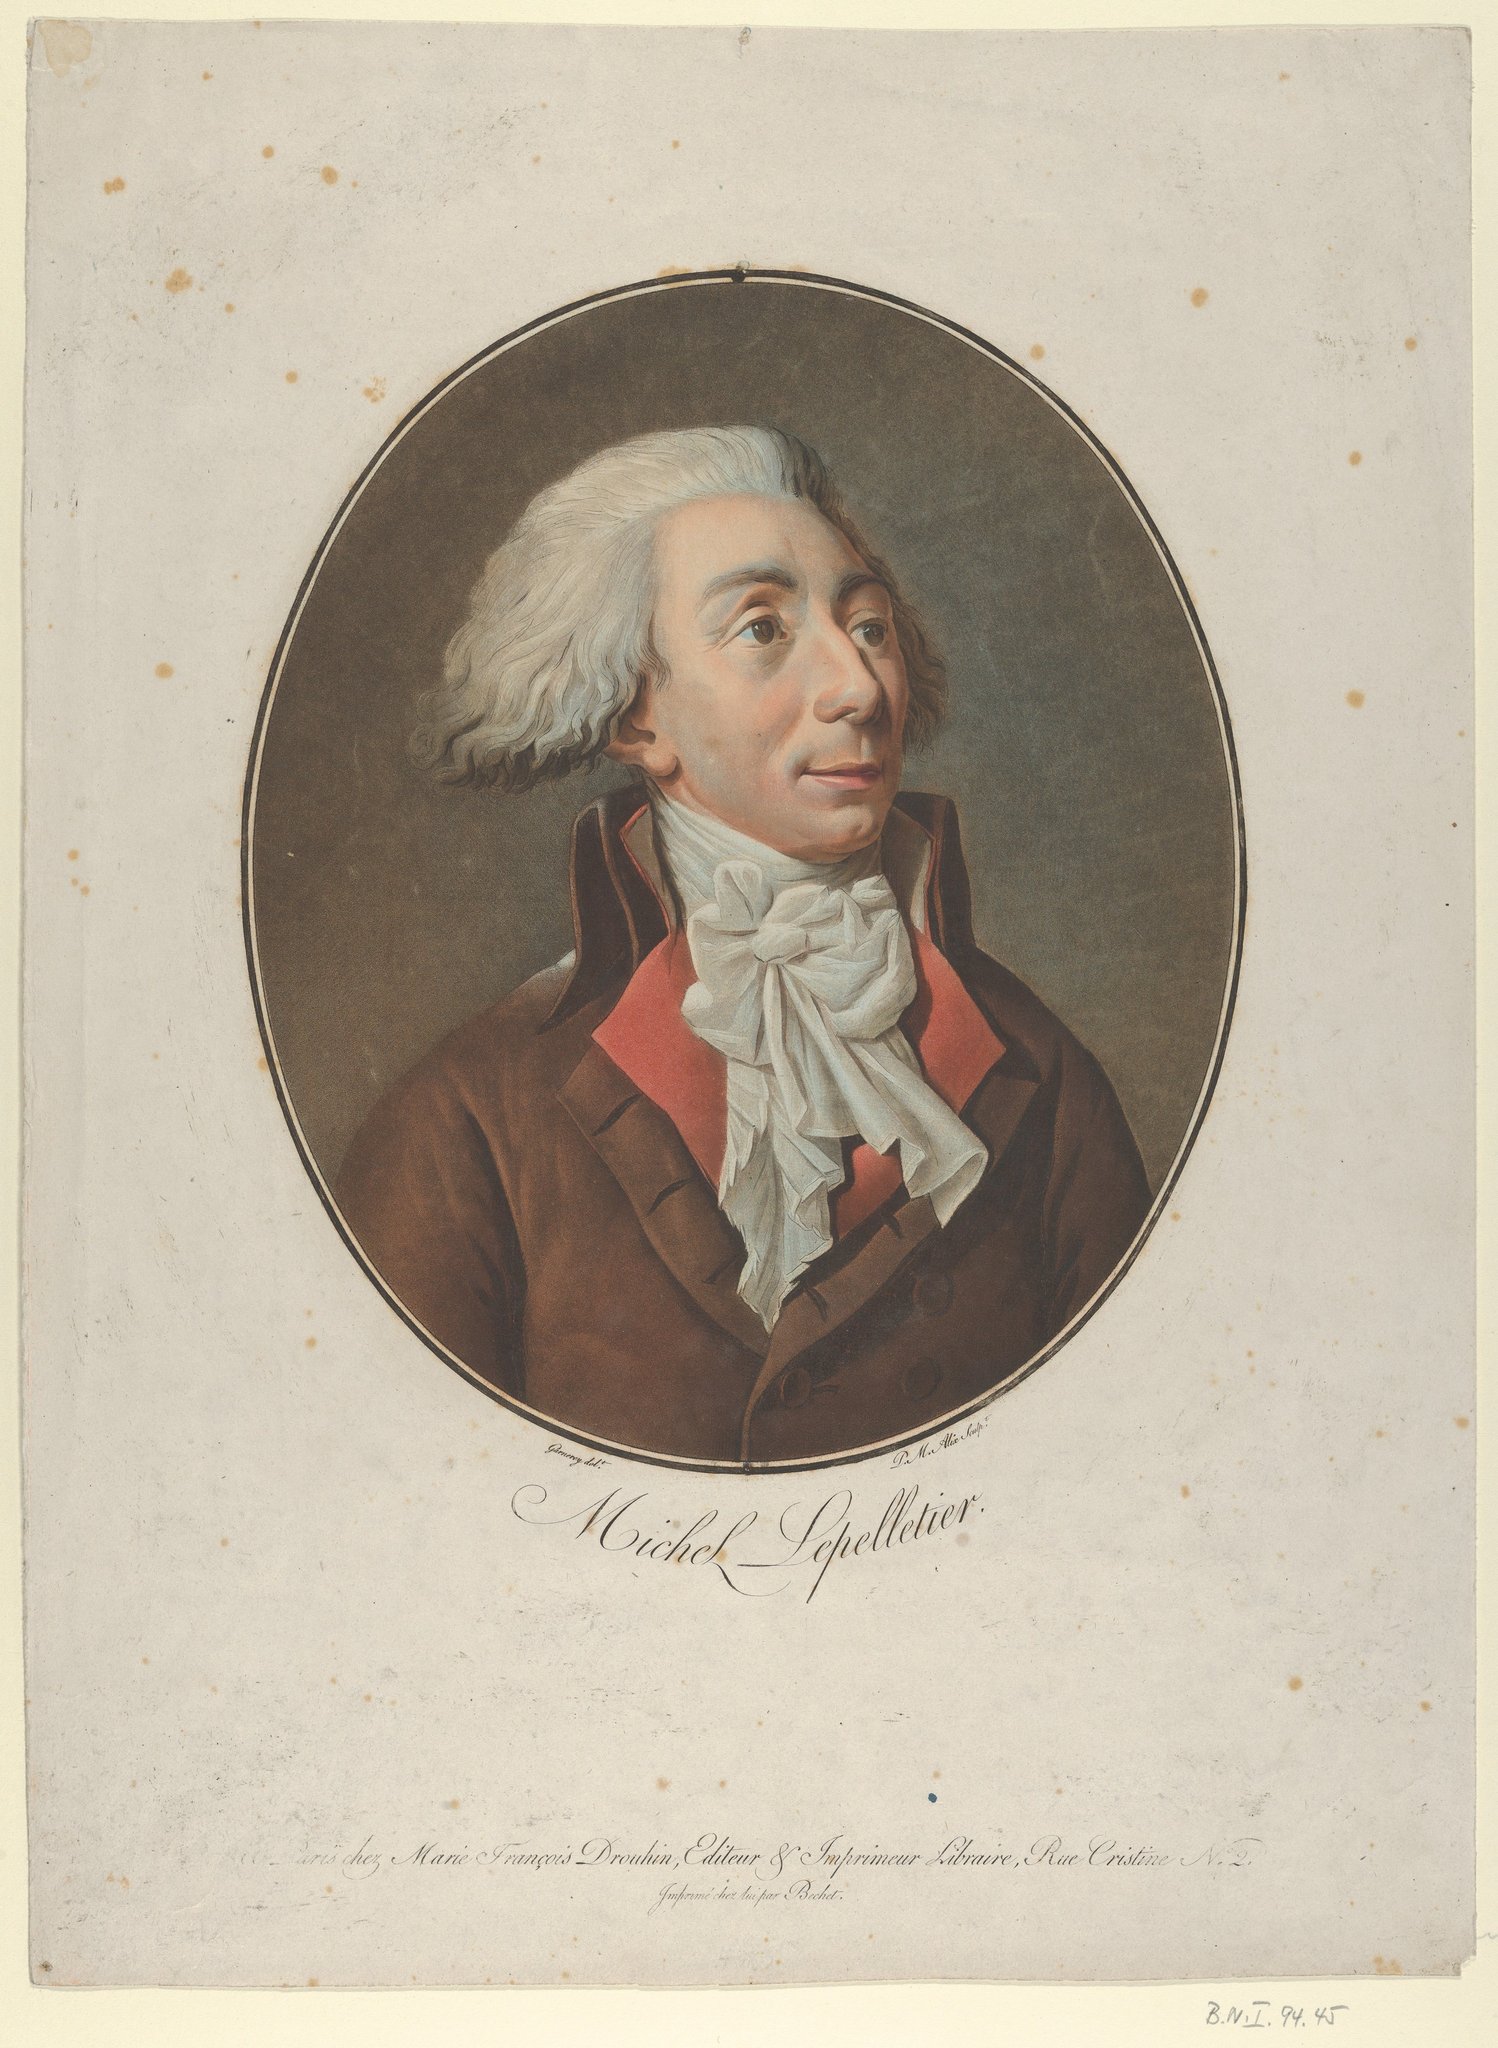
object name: print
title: Louis Michel Lepelletier de St. Fargeau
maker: pierre michel alix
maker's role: artist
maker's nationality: french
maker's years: 1762-1817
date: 1794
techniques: aquatint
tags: men,portraits